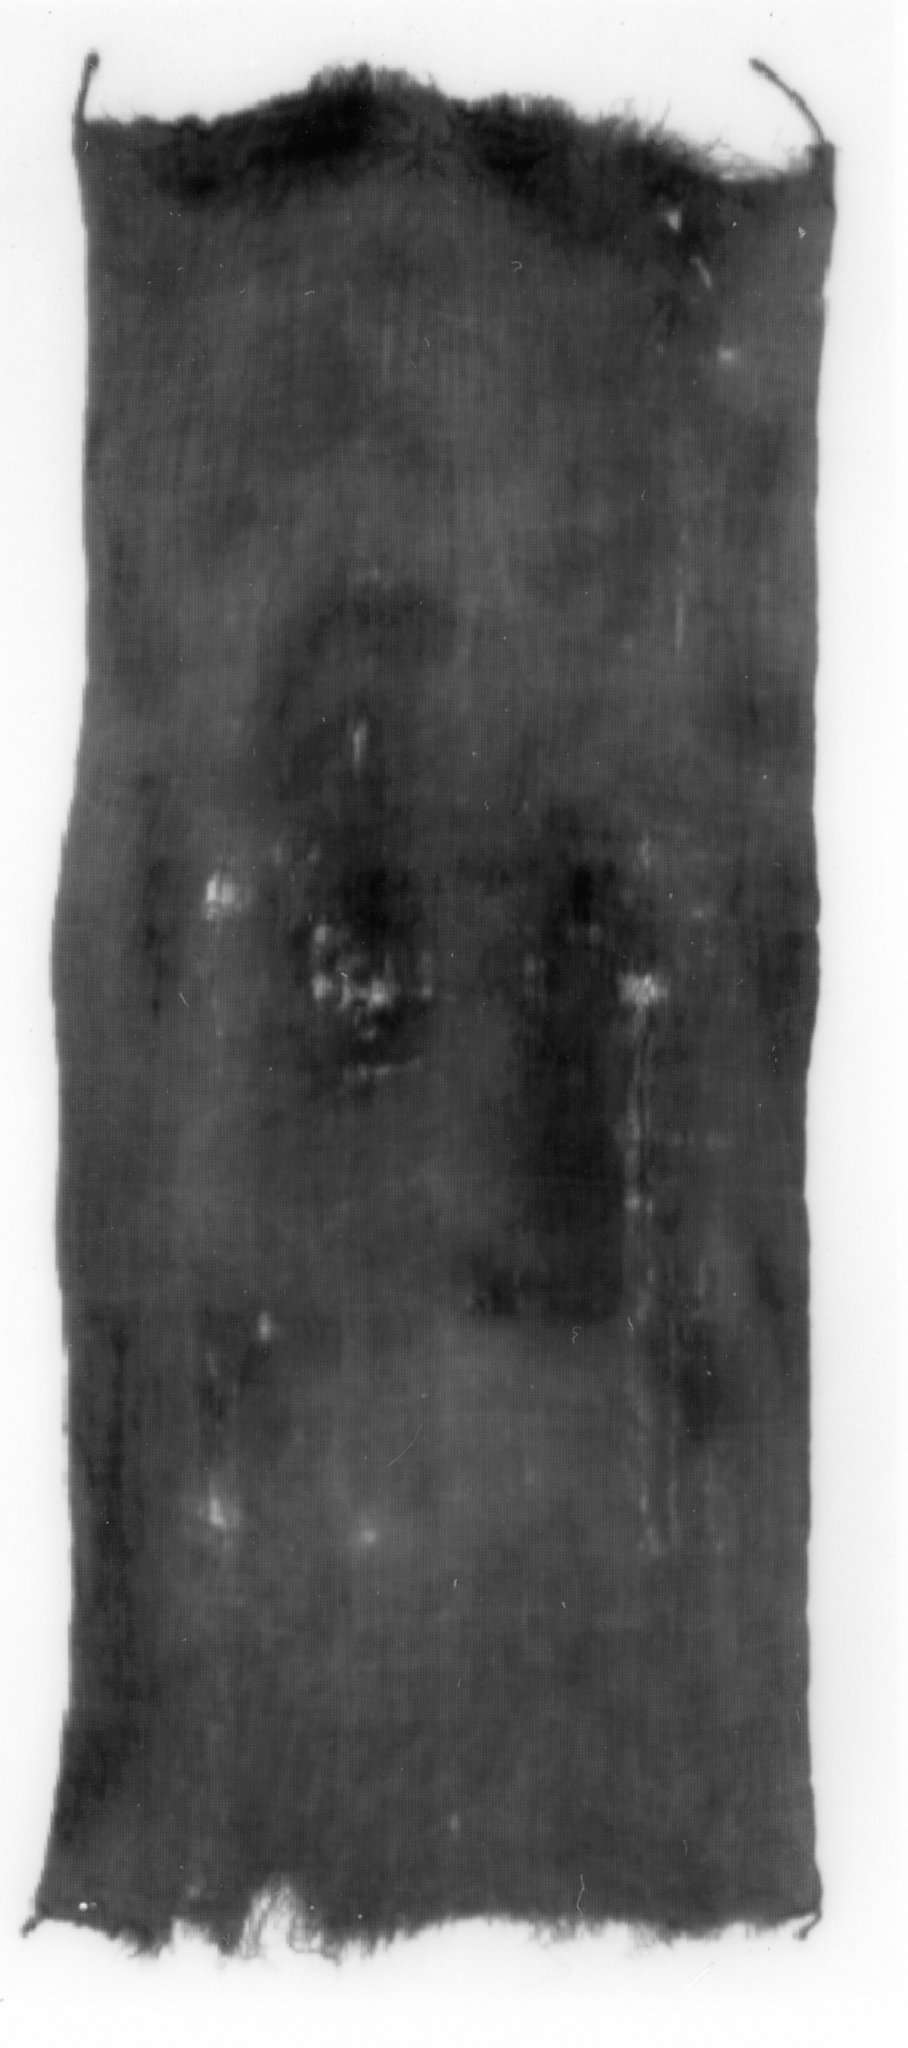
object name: sheet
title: Small Sheet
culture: coptic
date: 301-400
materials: linen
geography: egypt